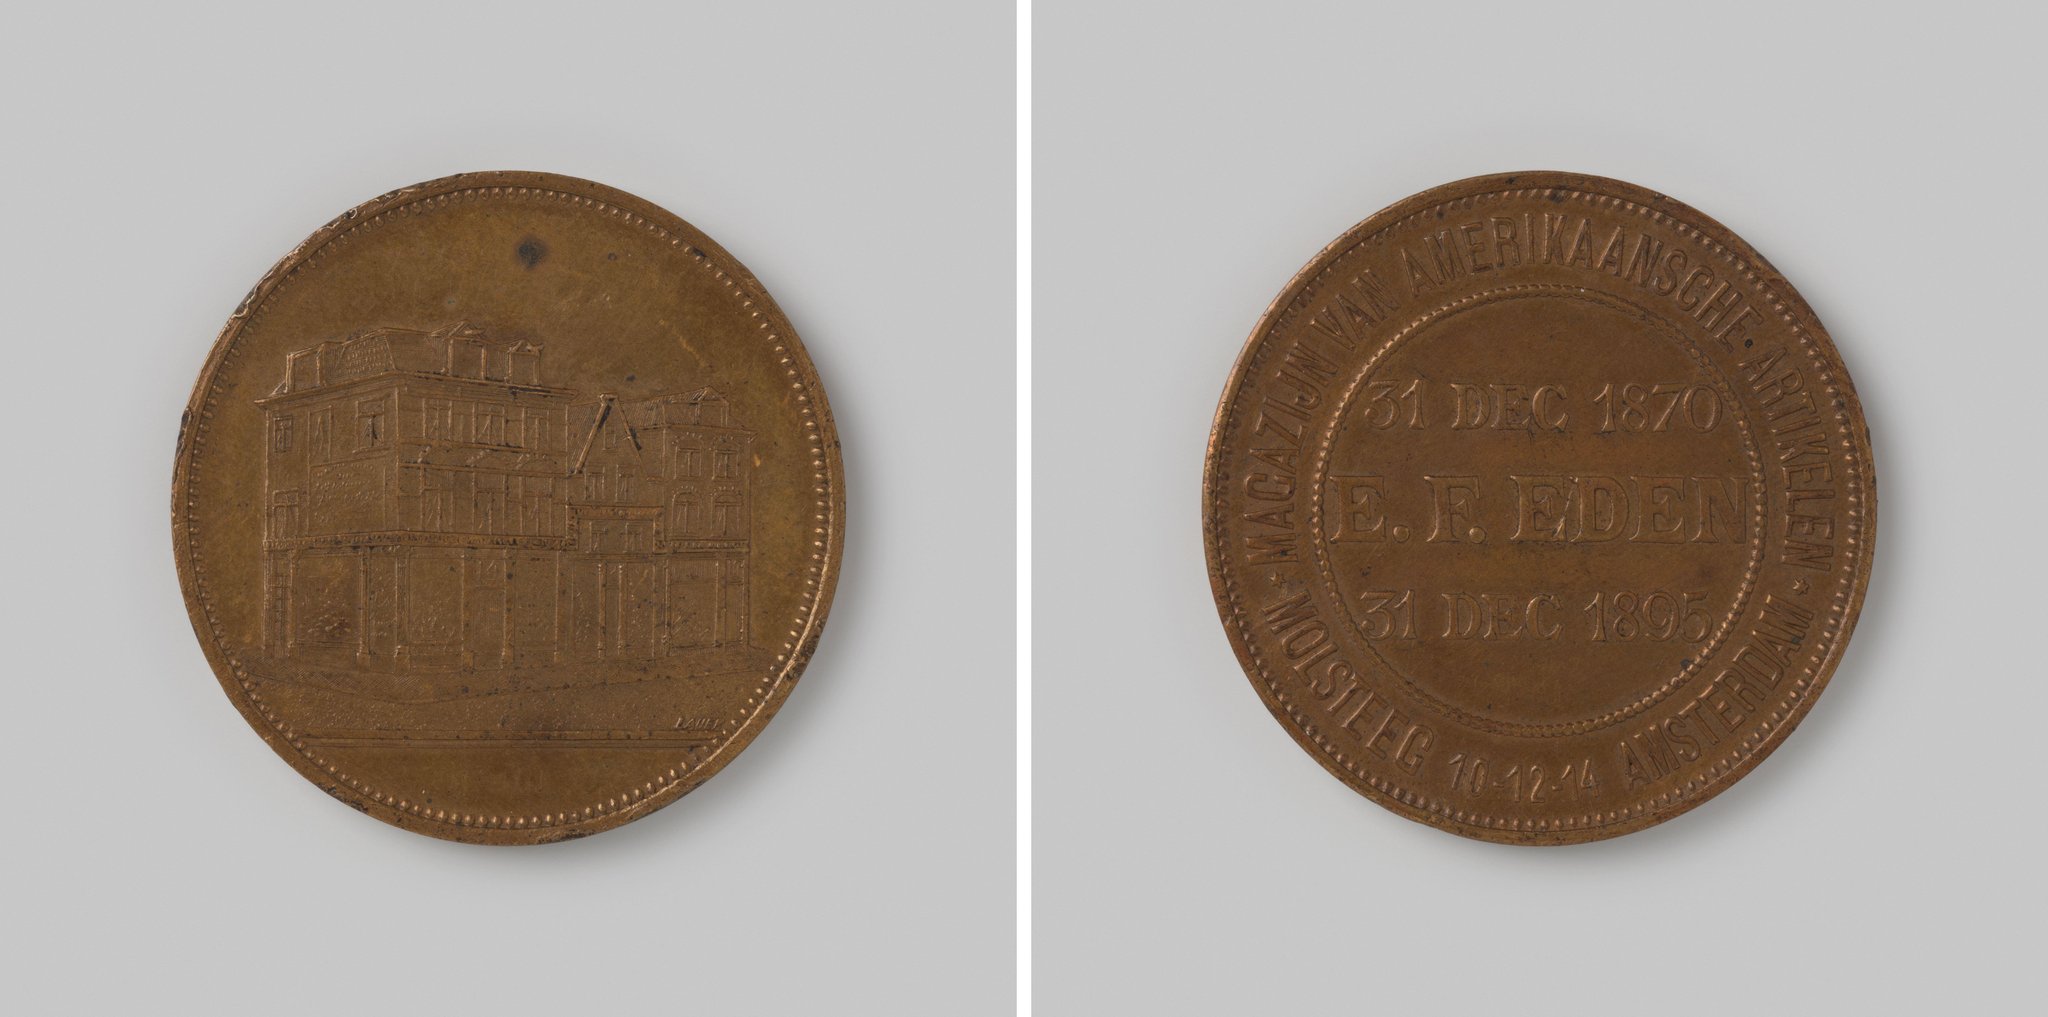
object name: adrespenning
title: Vijfentwintigjarig bestaan van de winkel van E.F. Eden te Amsterdam 1895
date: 1895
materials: brass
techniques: striking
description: Messing penning, op de voorzijde het aanzicht van de winkel schuin van rechts, op de keerzijde drie regels tekst met omschrift.